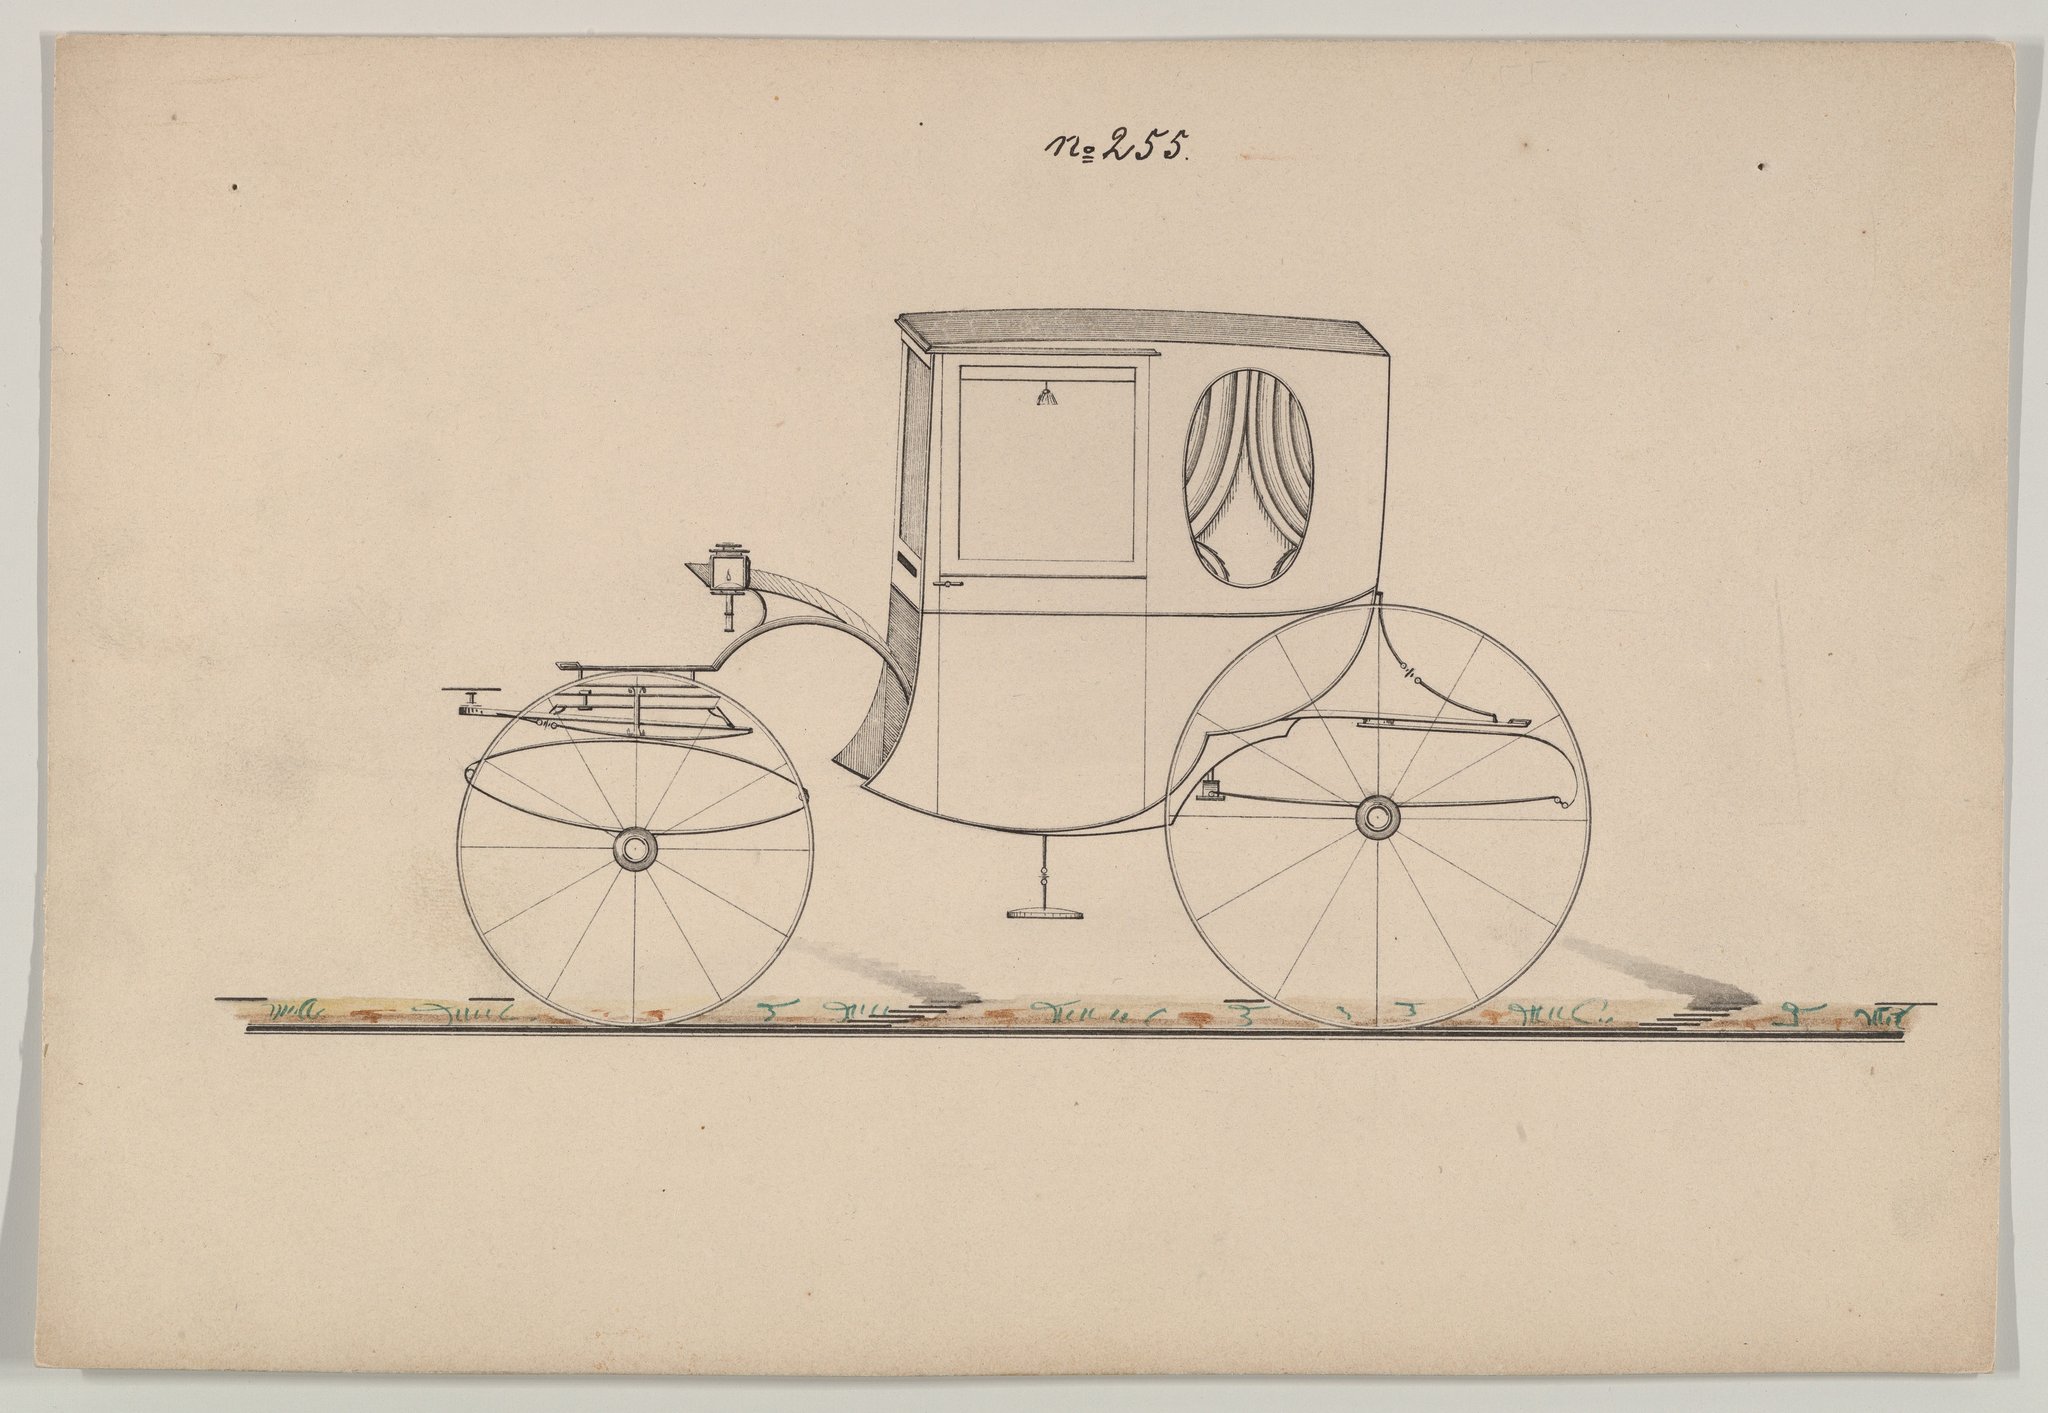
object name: drawing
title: Coupe #255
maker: brewster & co.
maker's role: manufacturer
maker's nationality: american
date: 1860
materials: gouache, ink, watercolor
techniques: pen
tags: carriages